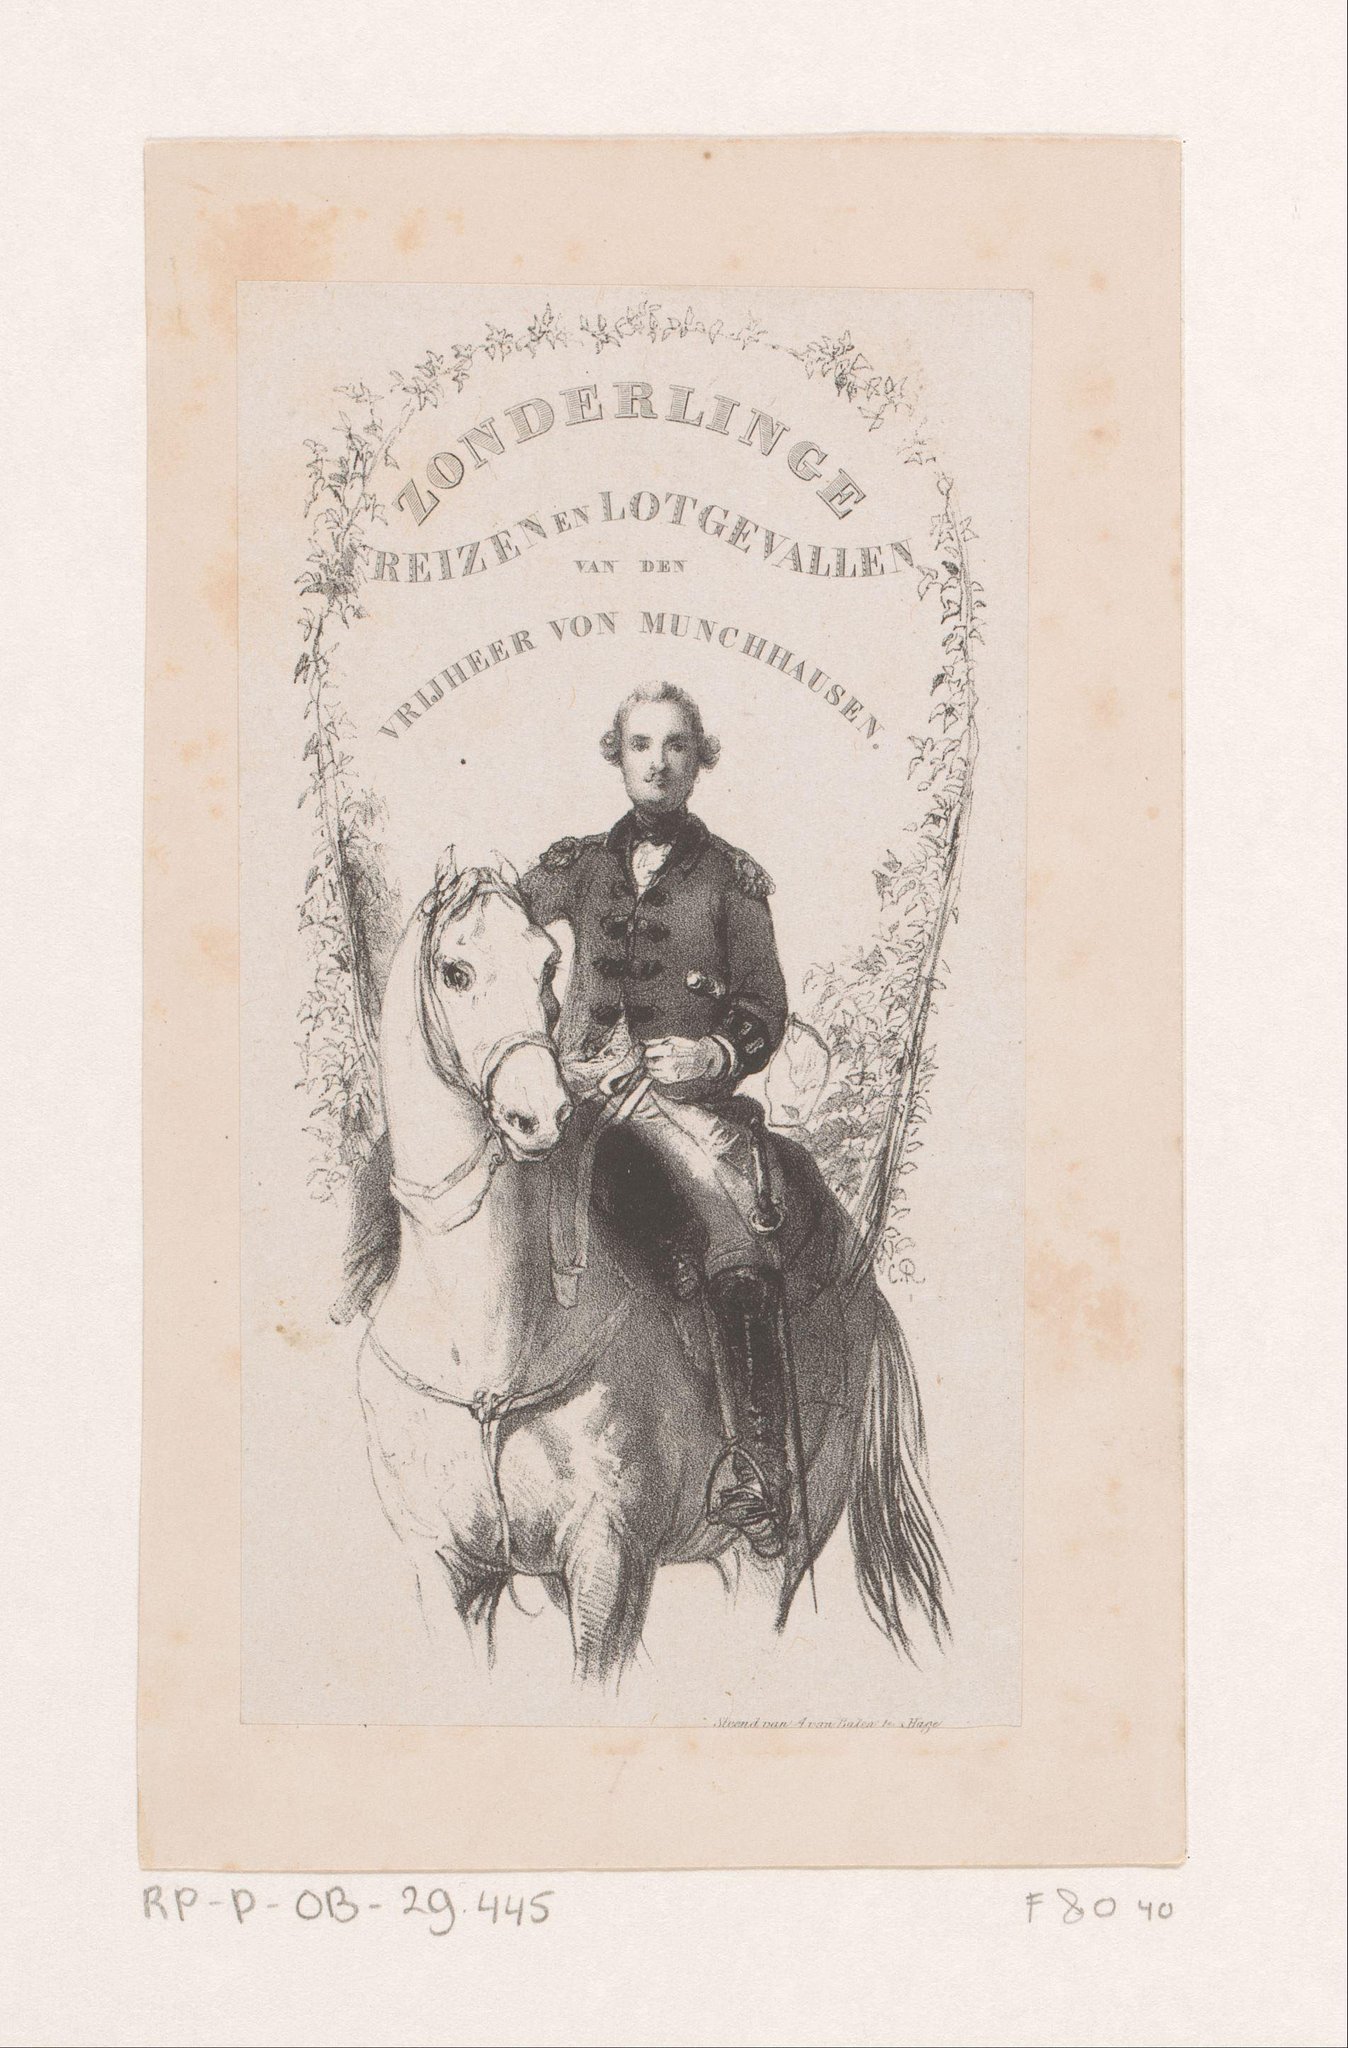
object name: book illustration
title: Baron von Münchhausen te paard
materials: paper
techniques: lithograph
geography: the hague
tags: baron münchausen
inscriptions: collector's mark: Lugt 2228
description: Prent uit: Raspe, Rudolf Erich. Zonderlinge reizen en lotgevallen van den Vrijheer von Münchhausen. Den Haag: Bisschop, J.H., 1843.